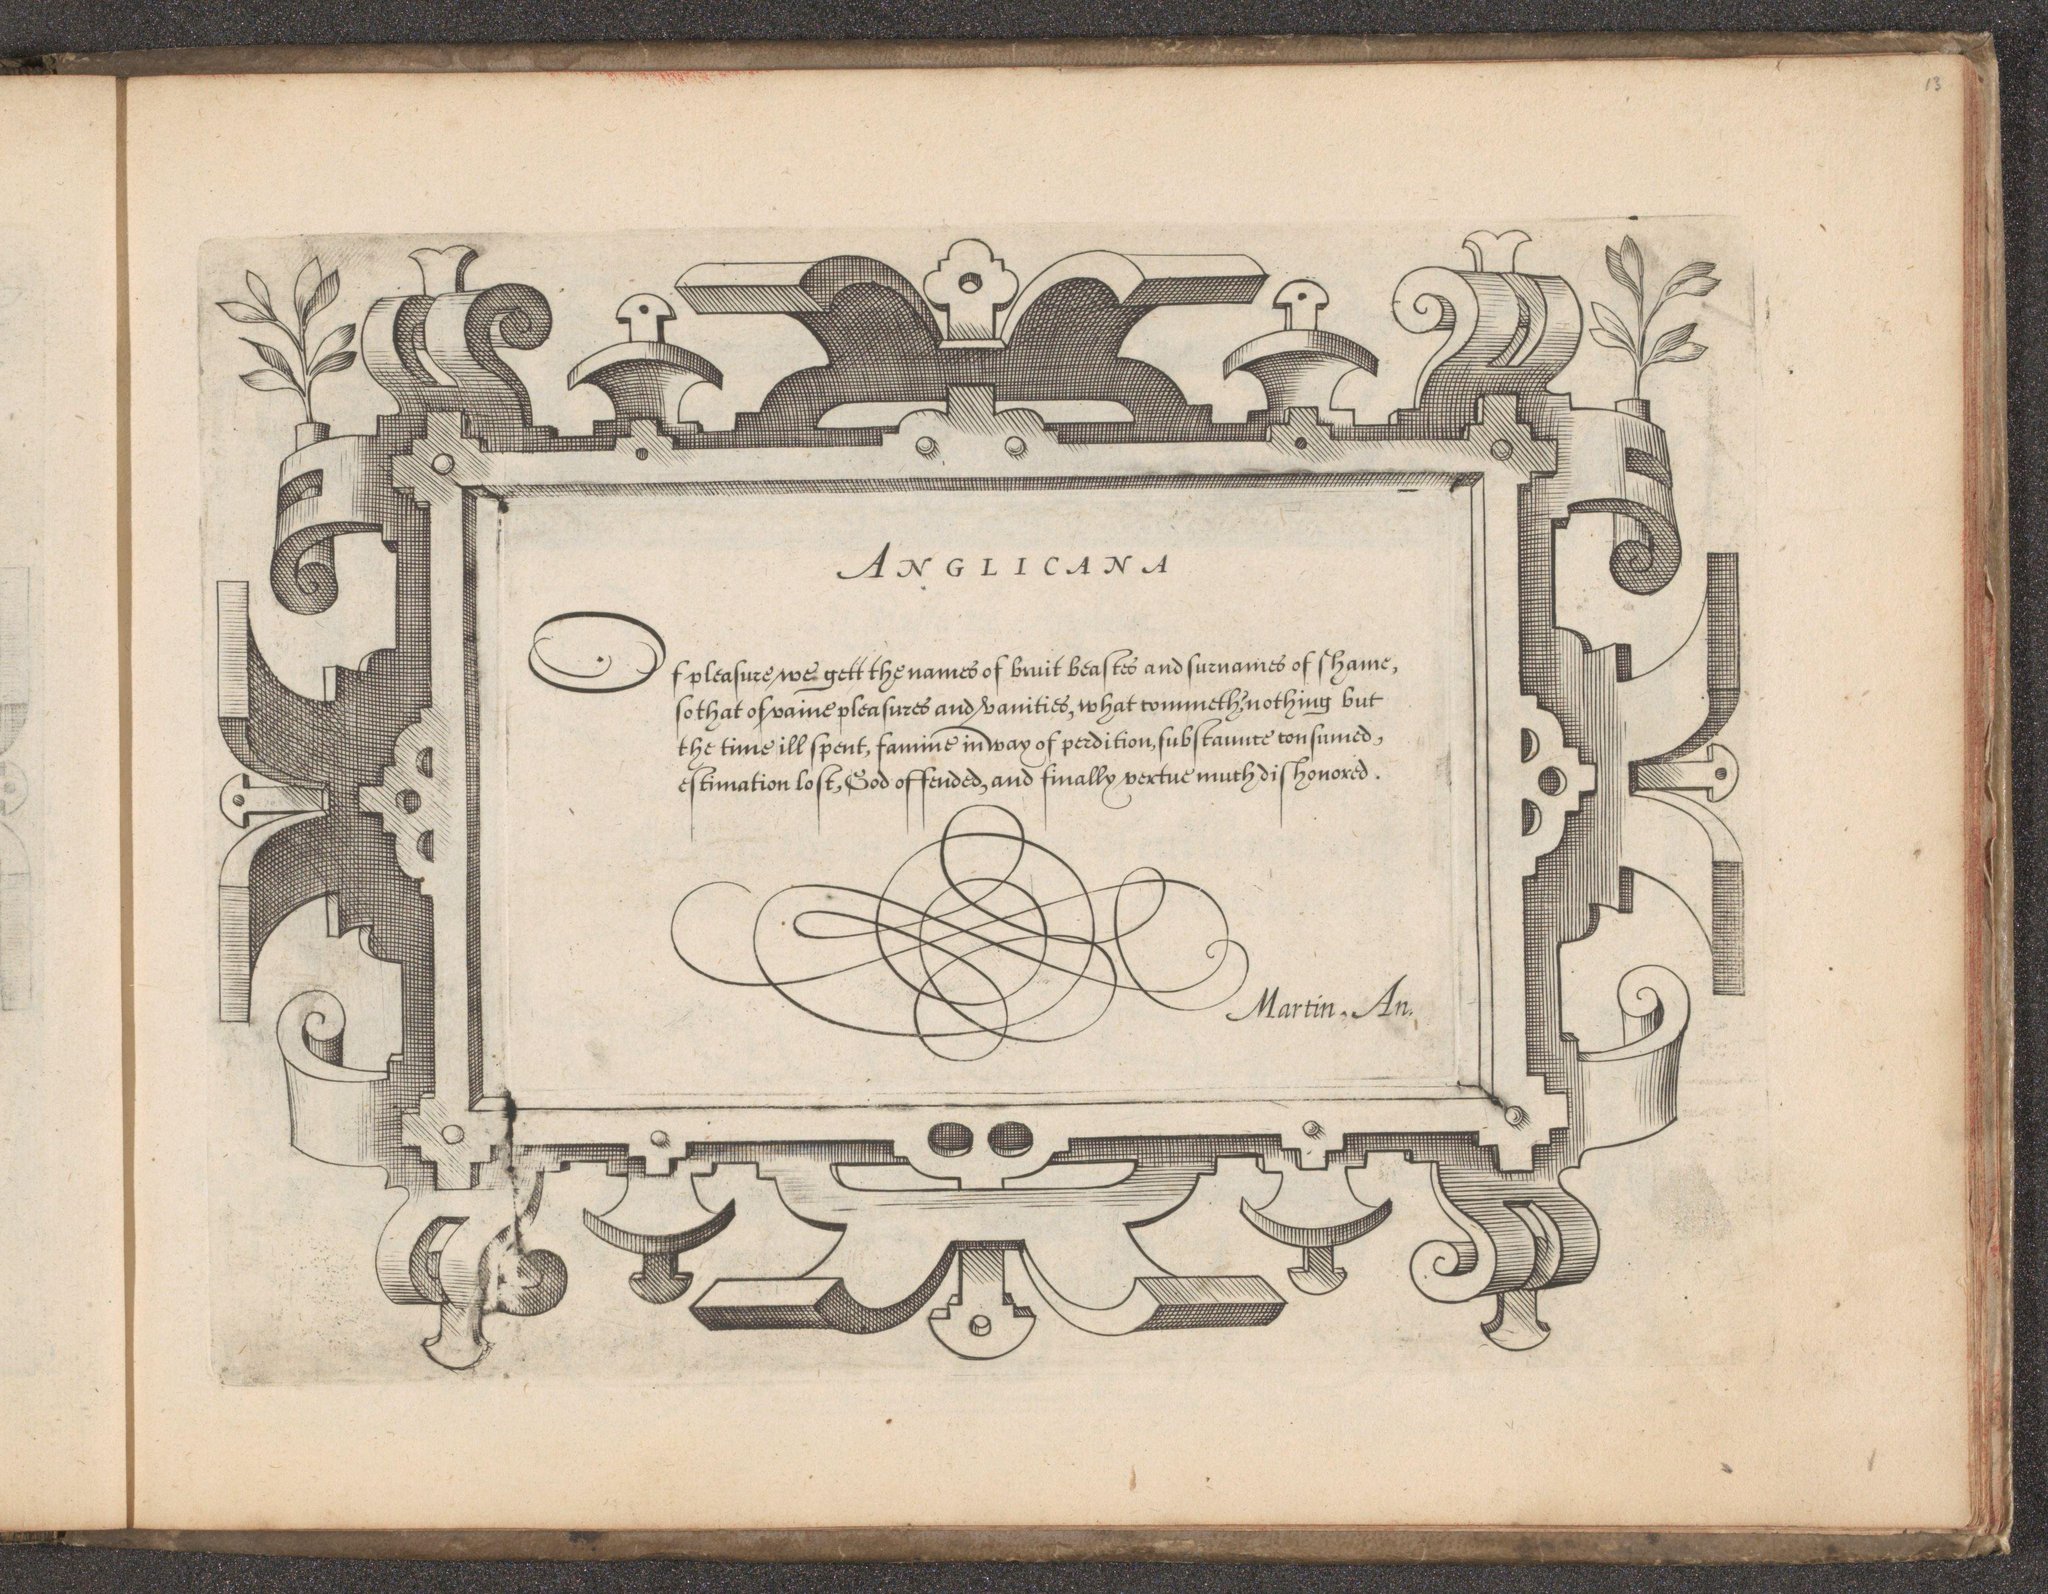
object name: print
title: Anglicana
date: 1614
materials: paper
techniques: engraving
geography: amsterdam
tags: scrollwork, strapwork ~ ornament, ornament ~ cartouche, calligraphy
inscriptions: signature and date: ‘Op titelblad: Judoco Hondio celatore. Amstelodami apud Joannem Janssonium. 1614’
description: Schrijfvoorbeeld in een gotische hand met een titel in het Latijn en vier regels tekst in het Engels. Daarbij wat krulwerk. Het voorbeeld is gevat in een rolwerkcartouche. De prent maakt deel uit van een album.